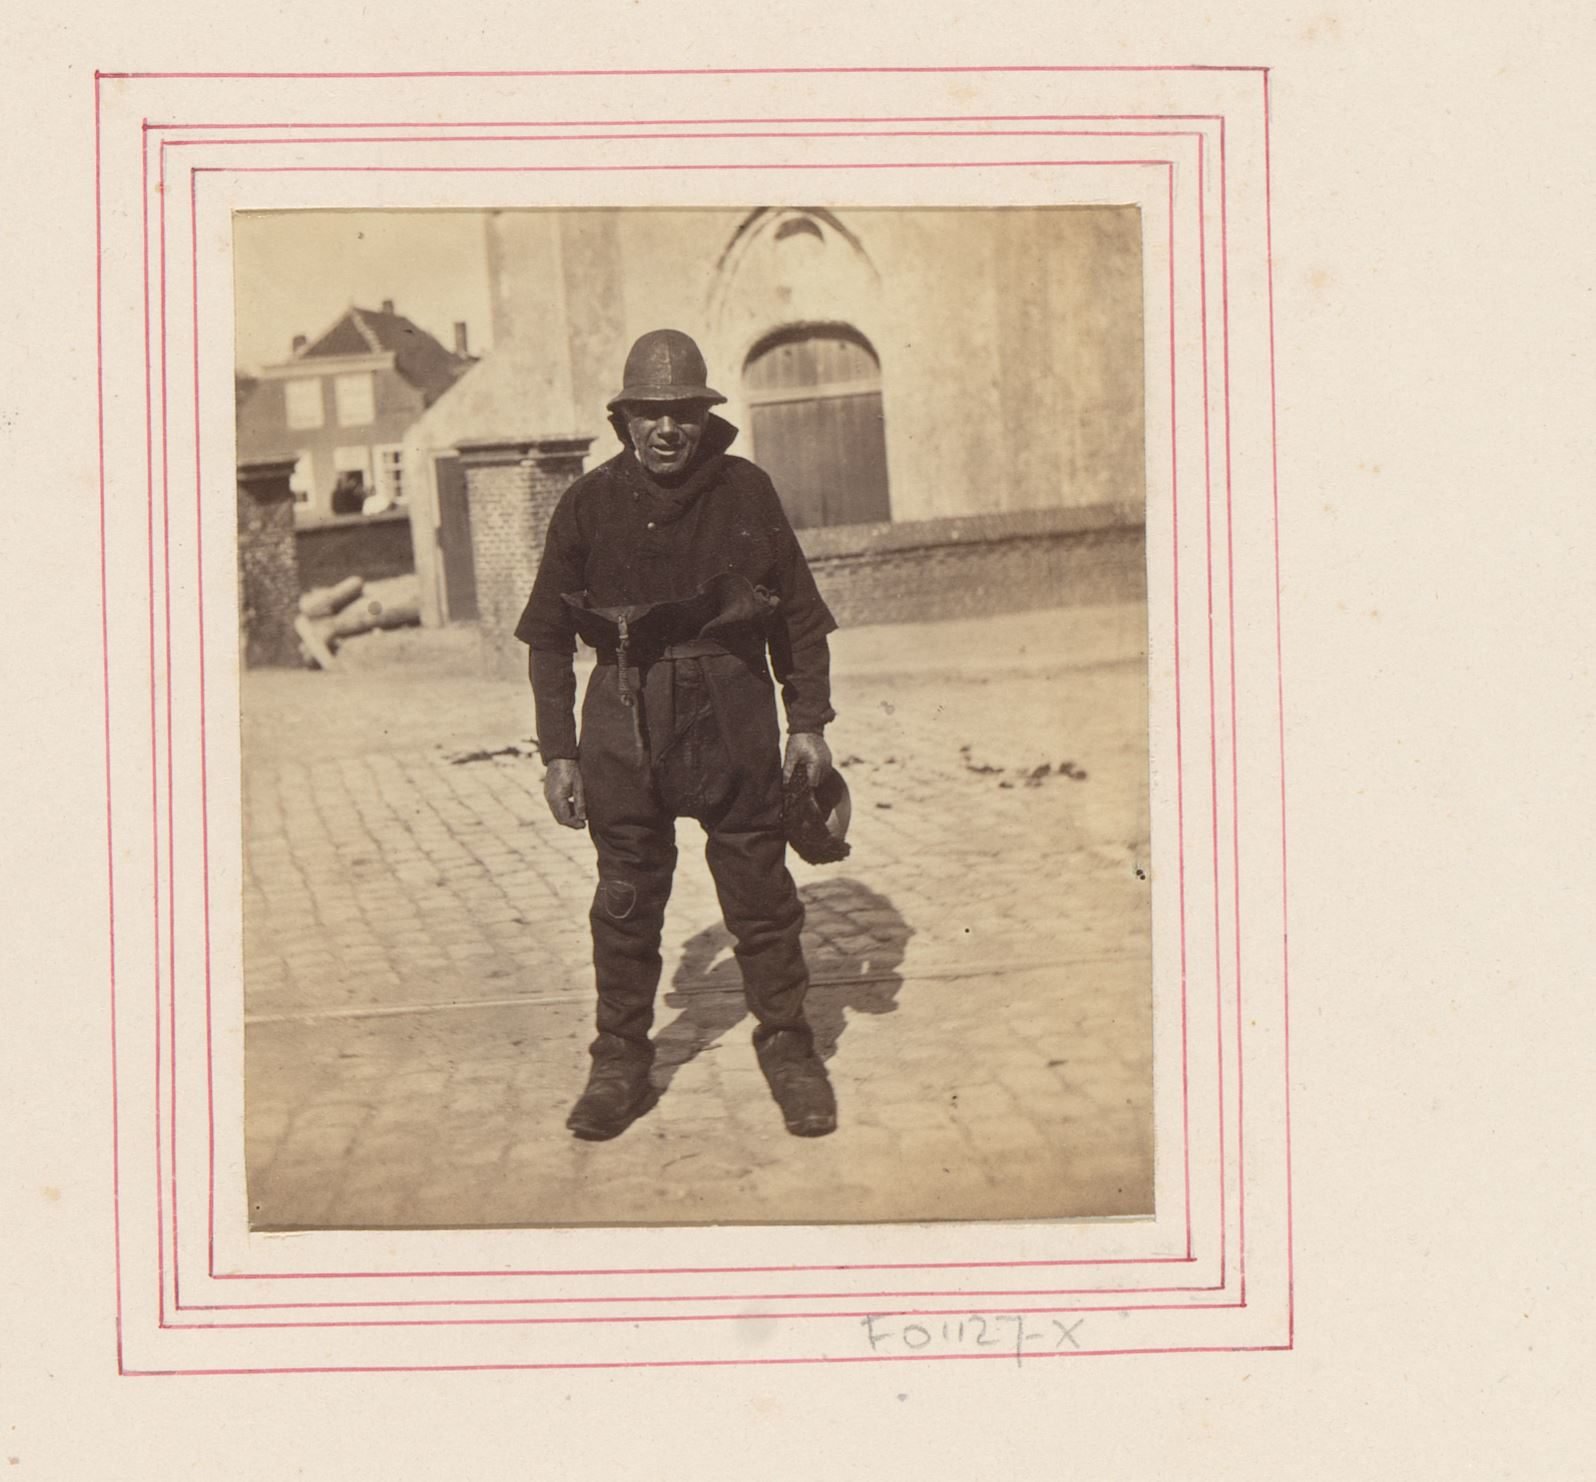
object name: photograph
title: Portret van een onbekende Scheveningse visser, staand voor de Oude Kerk in Den Haag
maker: Anonymous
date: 1870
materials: photographic support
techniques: albumen print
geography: the hague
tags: fisherman, the hague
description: Onderdeel van Album met foto's en litho's van bezienswaardigheden in Noord- en Zuid-Hollandse steden, schilderijen en klederdrachten.